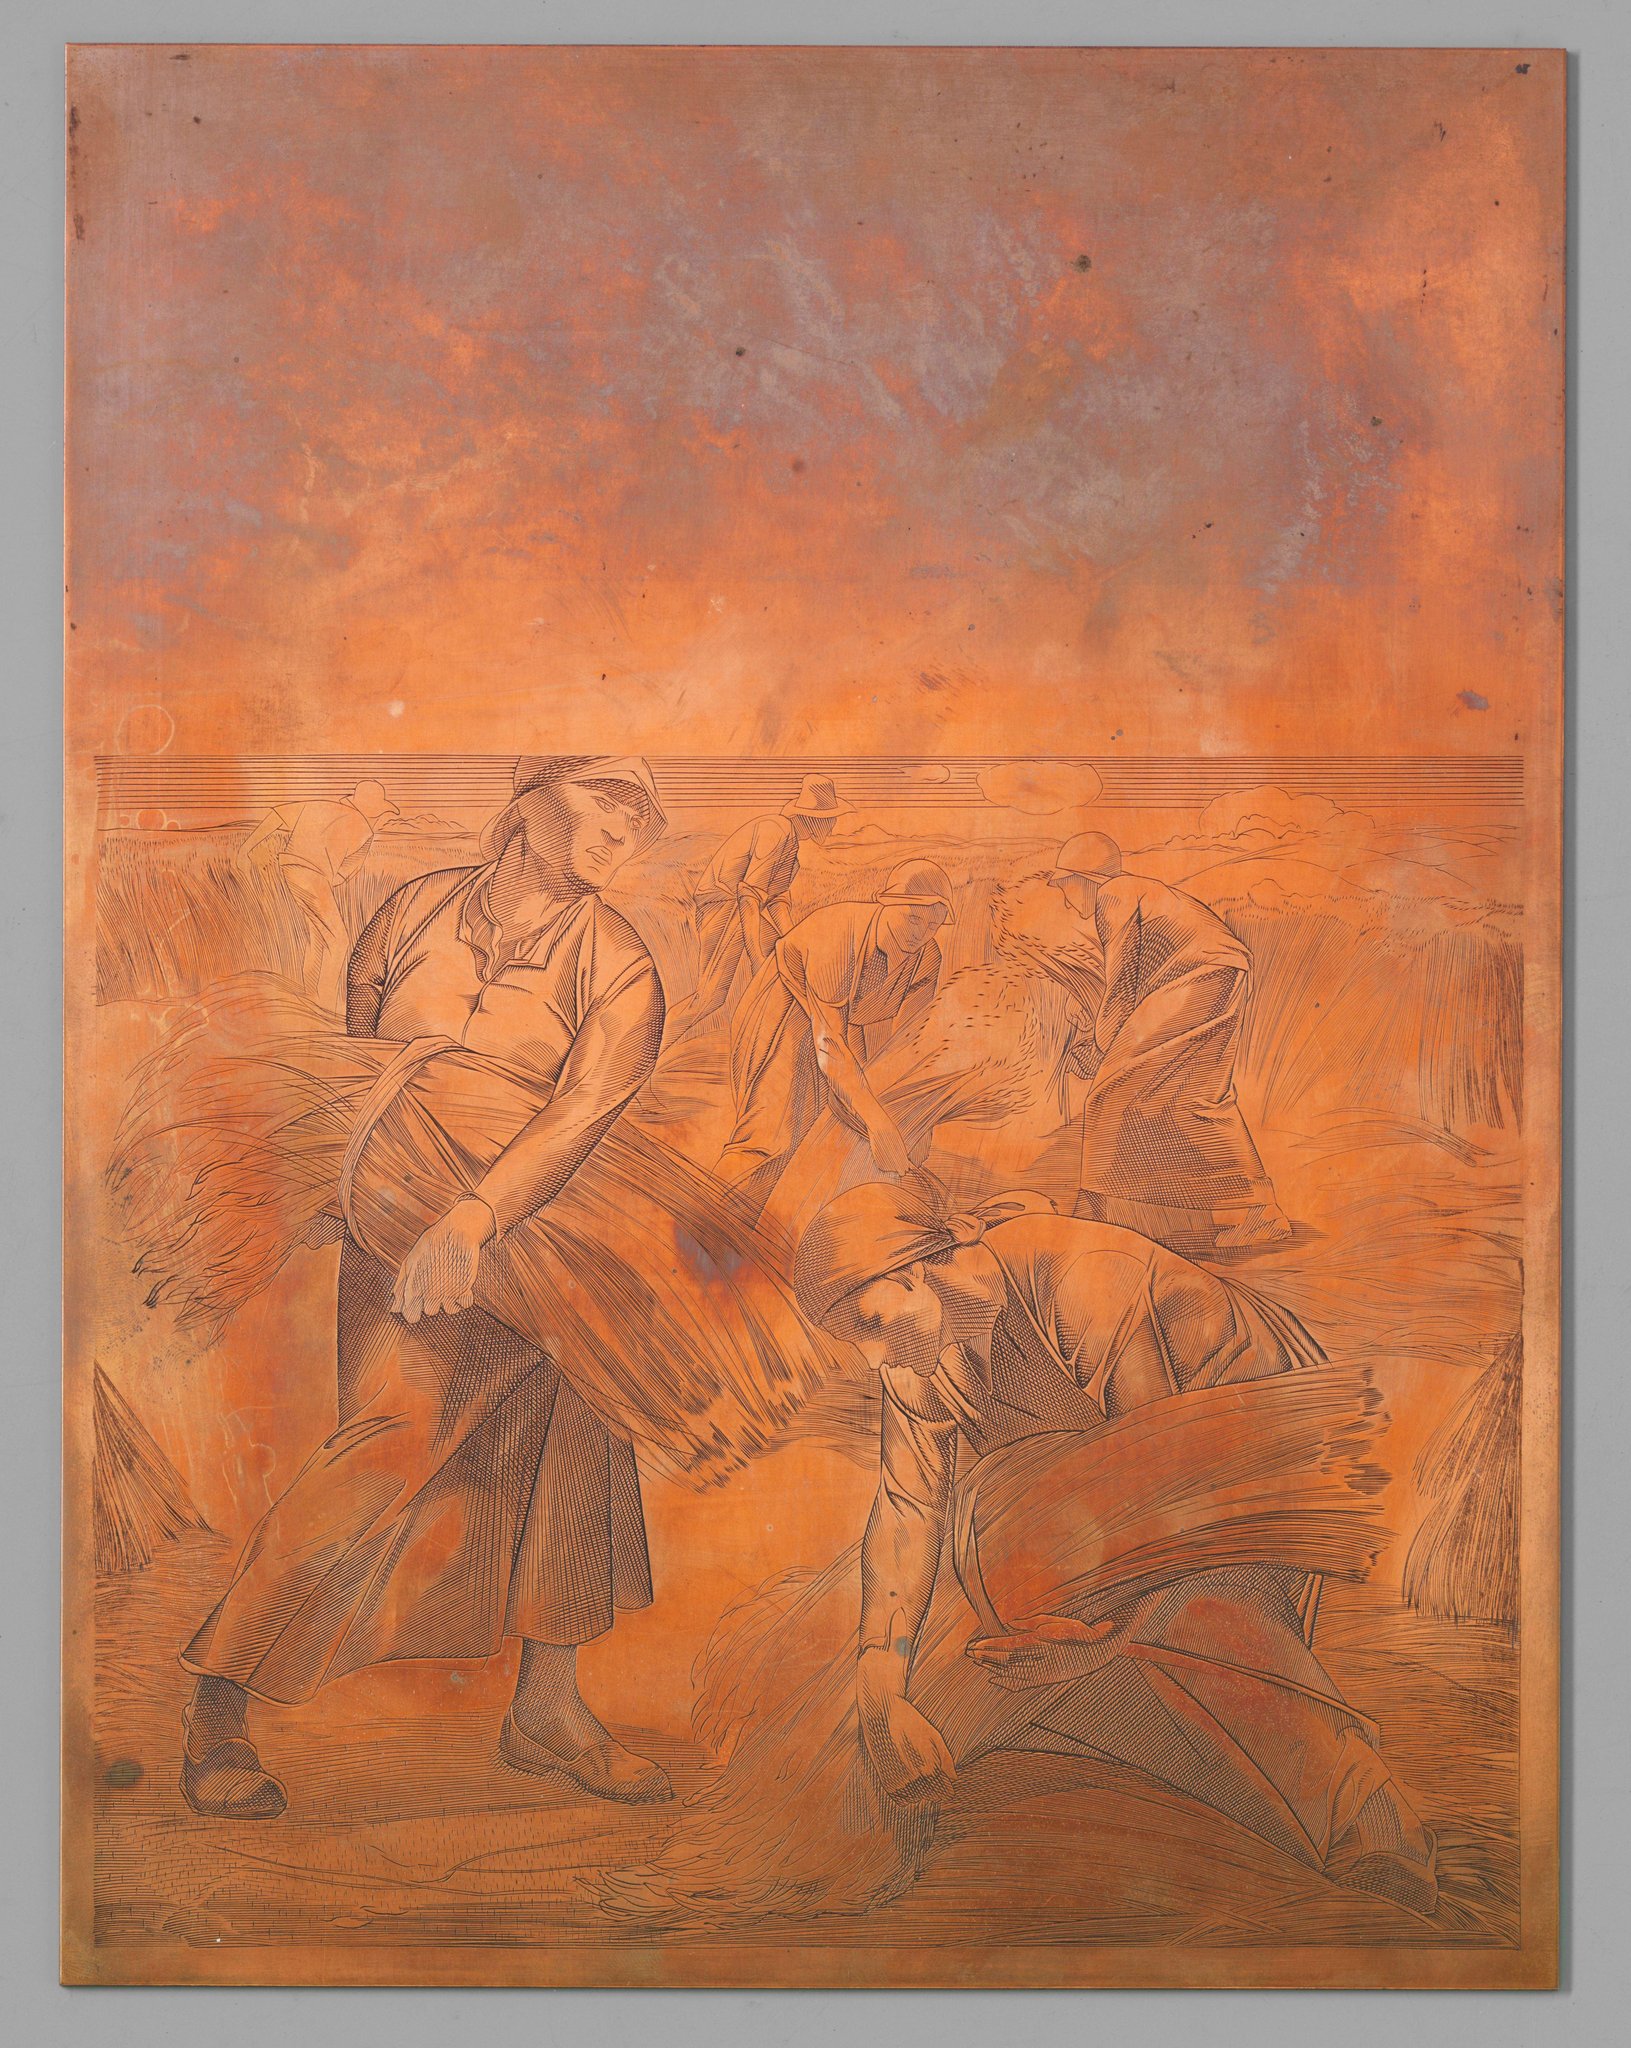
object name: copper plate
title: Vrouwen werken op het land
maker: johannes josephus aarts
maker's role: draughtsman, print maker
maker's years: 1871-1934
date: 1881-1934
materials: copper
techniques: engraving